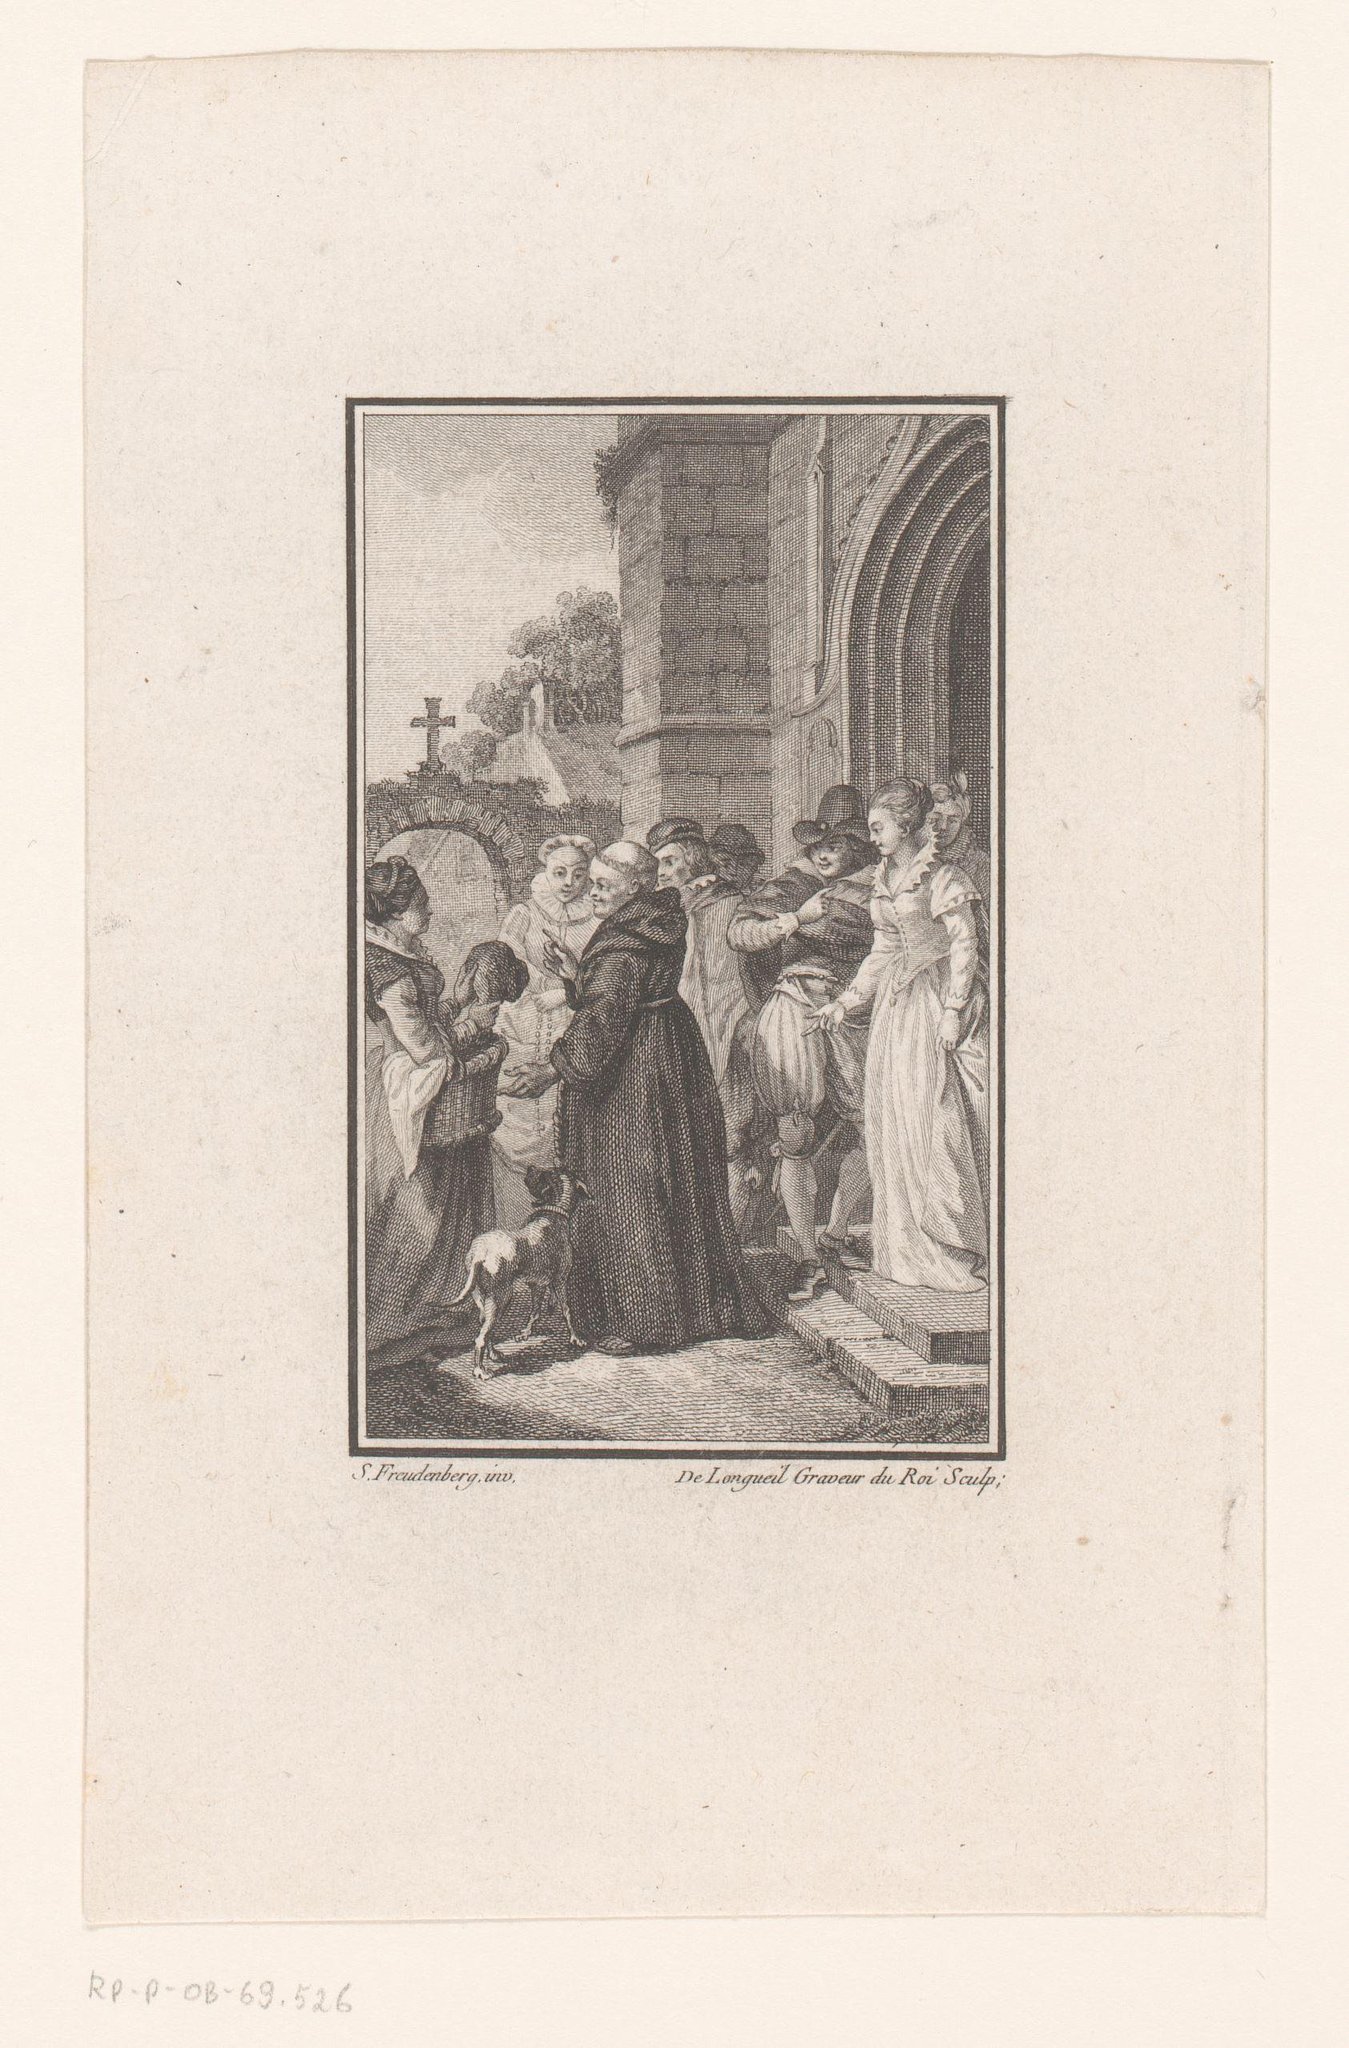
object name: book illustration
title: Uitgaande kerkgangers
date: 1780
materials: paper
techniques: engraving, etching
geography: france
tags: leaving the church after service, monk(s), friar(s)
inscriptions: collector's mark: Lugt 2228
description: Prent uit: Margaretha van Frankrijk. Les nouvelles de Marguerite, reine de Navarre. Bern: La Nouvelle Société Typographique, 1780.